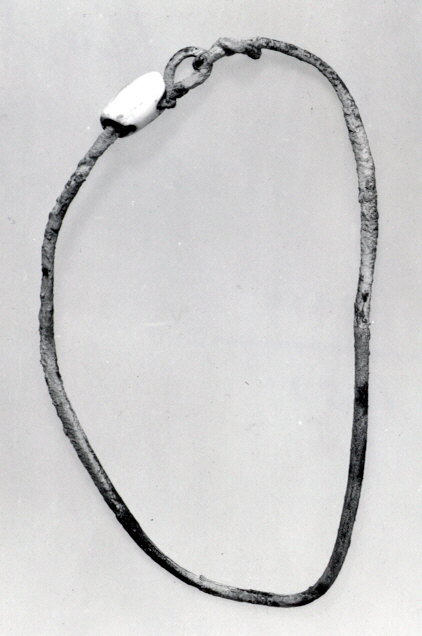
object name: neck ring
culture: parthian or sasanian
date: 101-400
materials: iron, paint, shell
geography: iran